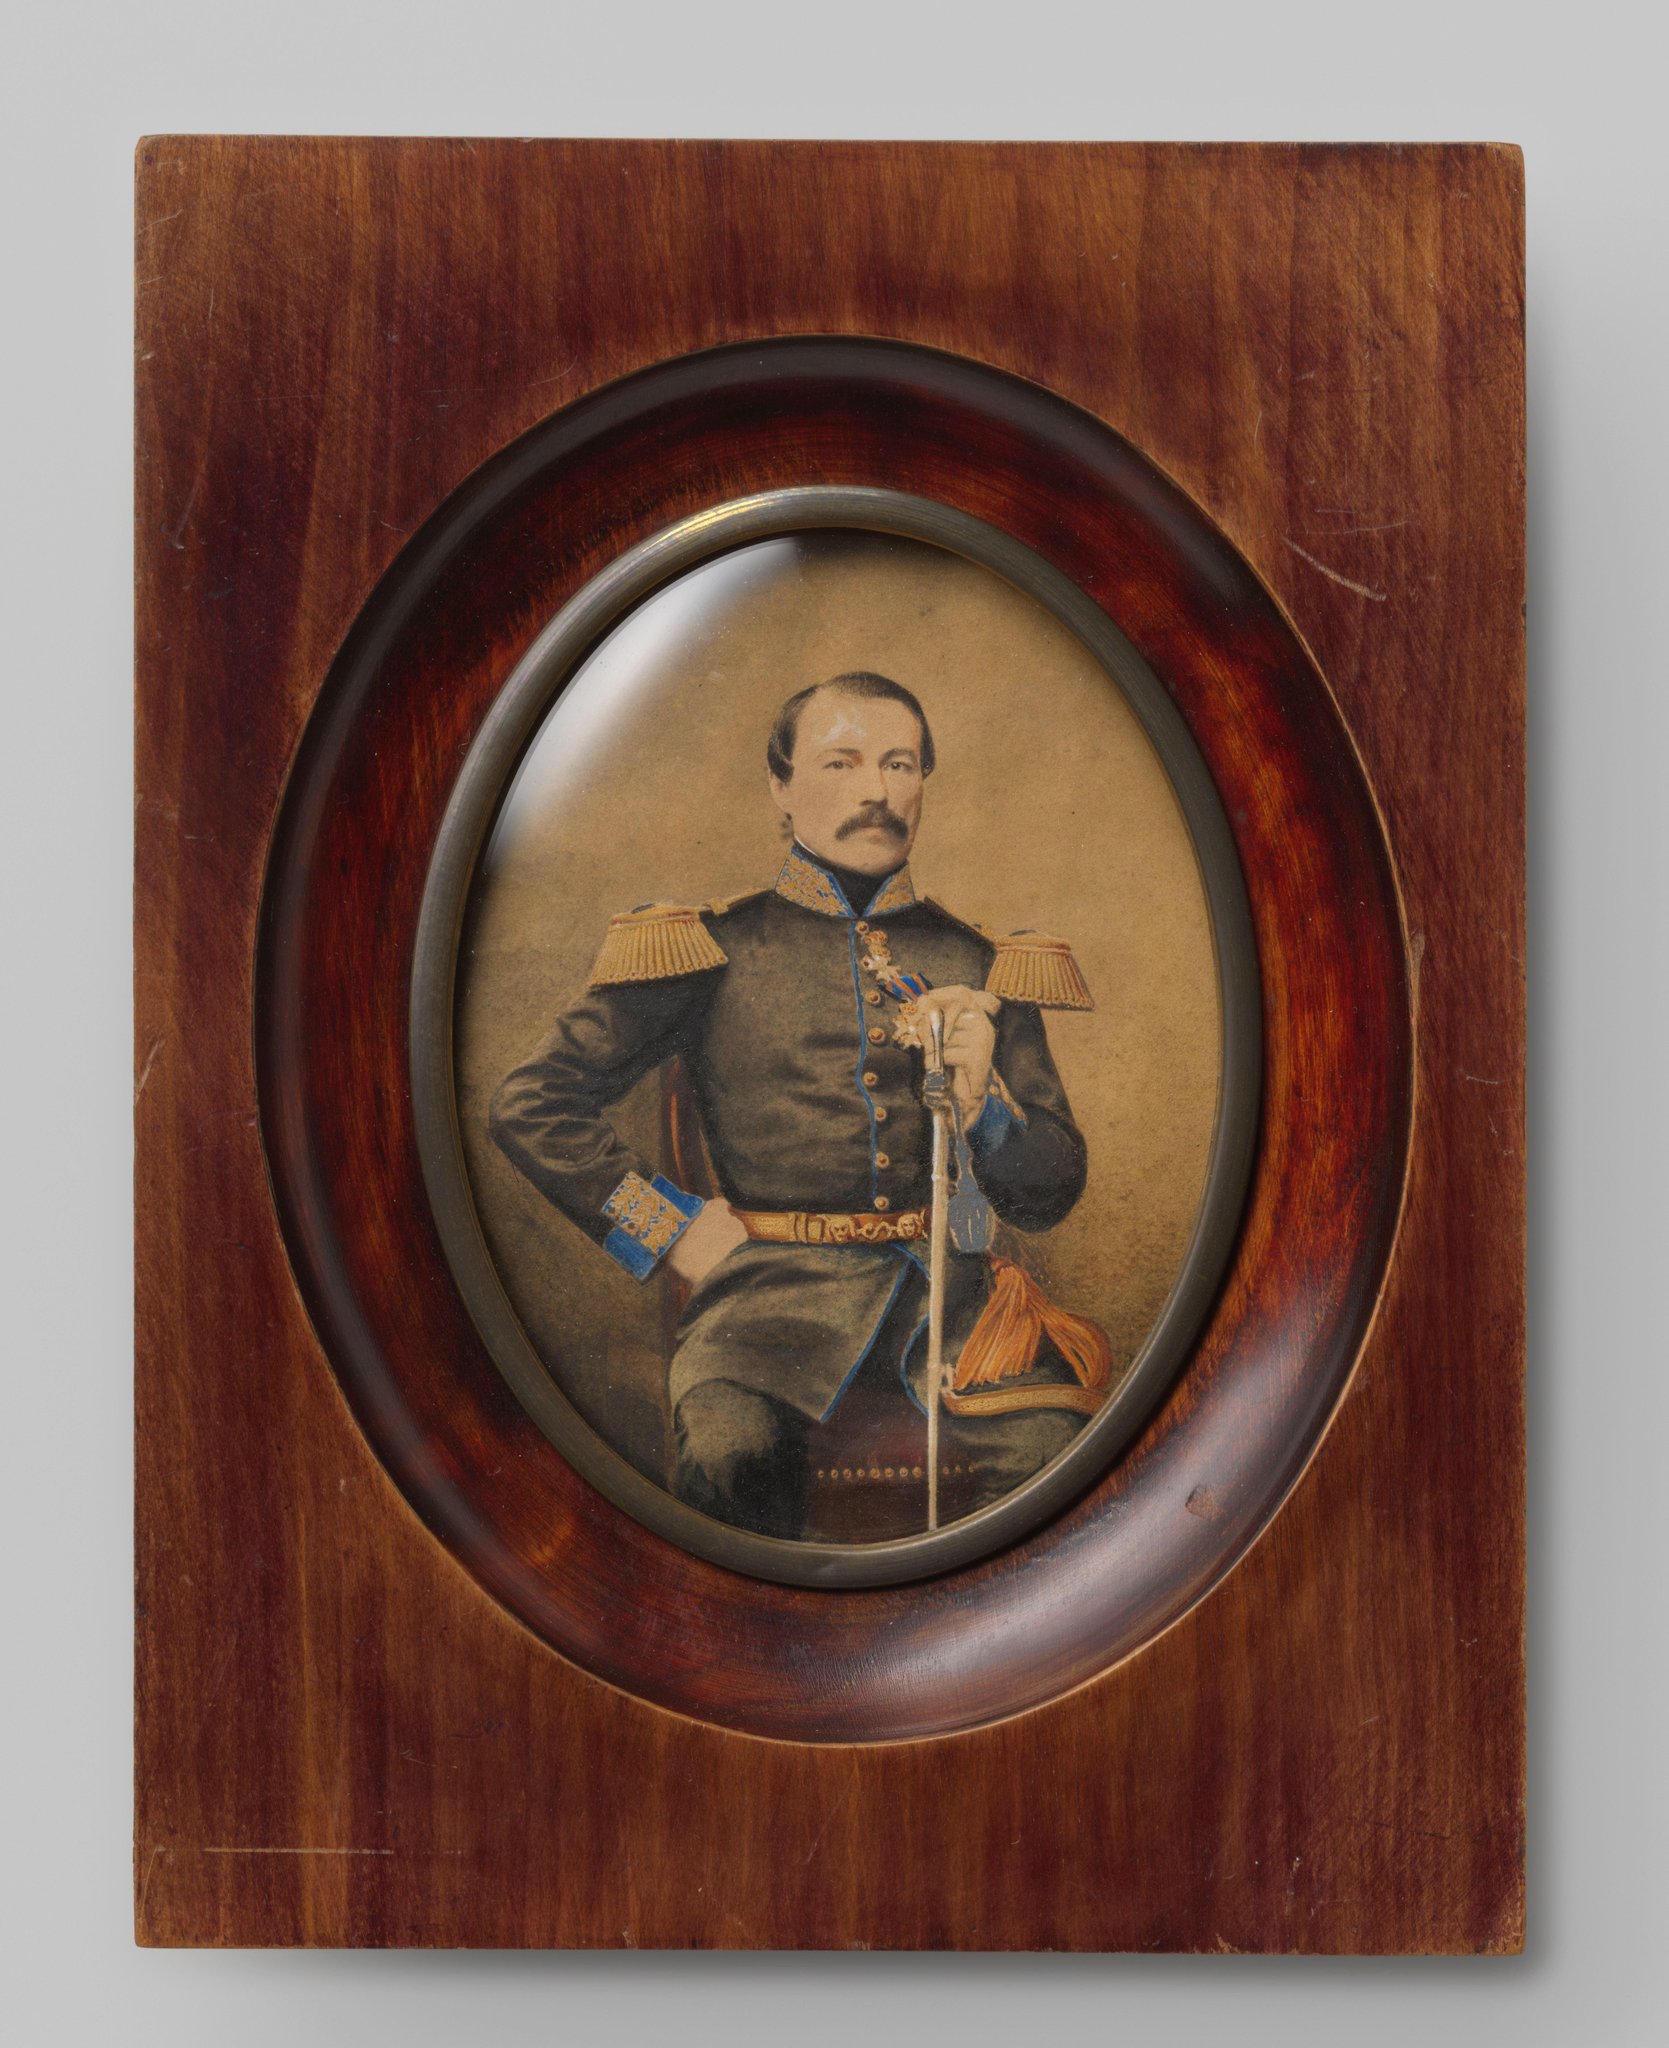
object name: frame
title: Portret van een onbekende man in uniform met sabel en epauletten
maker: Anonymous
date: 1860-1900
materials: cardboard, glass, metal, paper, wood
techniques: albumen print, hand coloring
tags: adult man, anonymous historical person portrayed, (military) uniforms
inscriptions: label: ‘ENCADREMENTEN/ KUNSTHANDEL/ JAN. EDEL/ ROELOF HARTSTRAAT 27/ TEL. 22180/ AMSTERDAM’